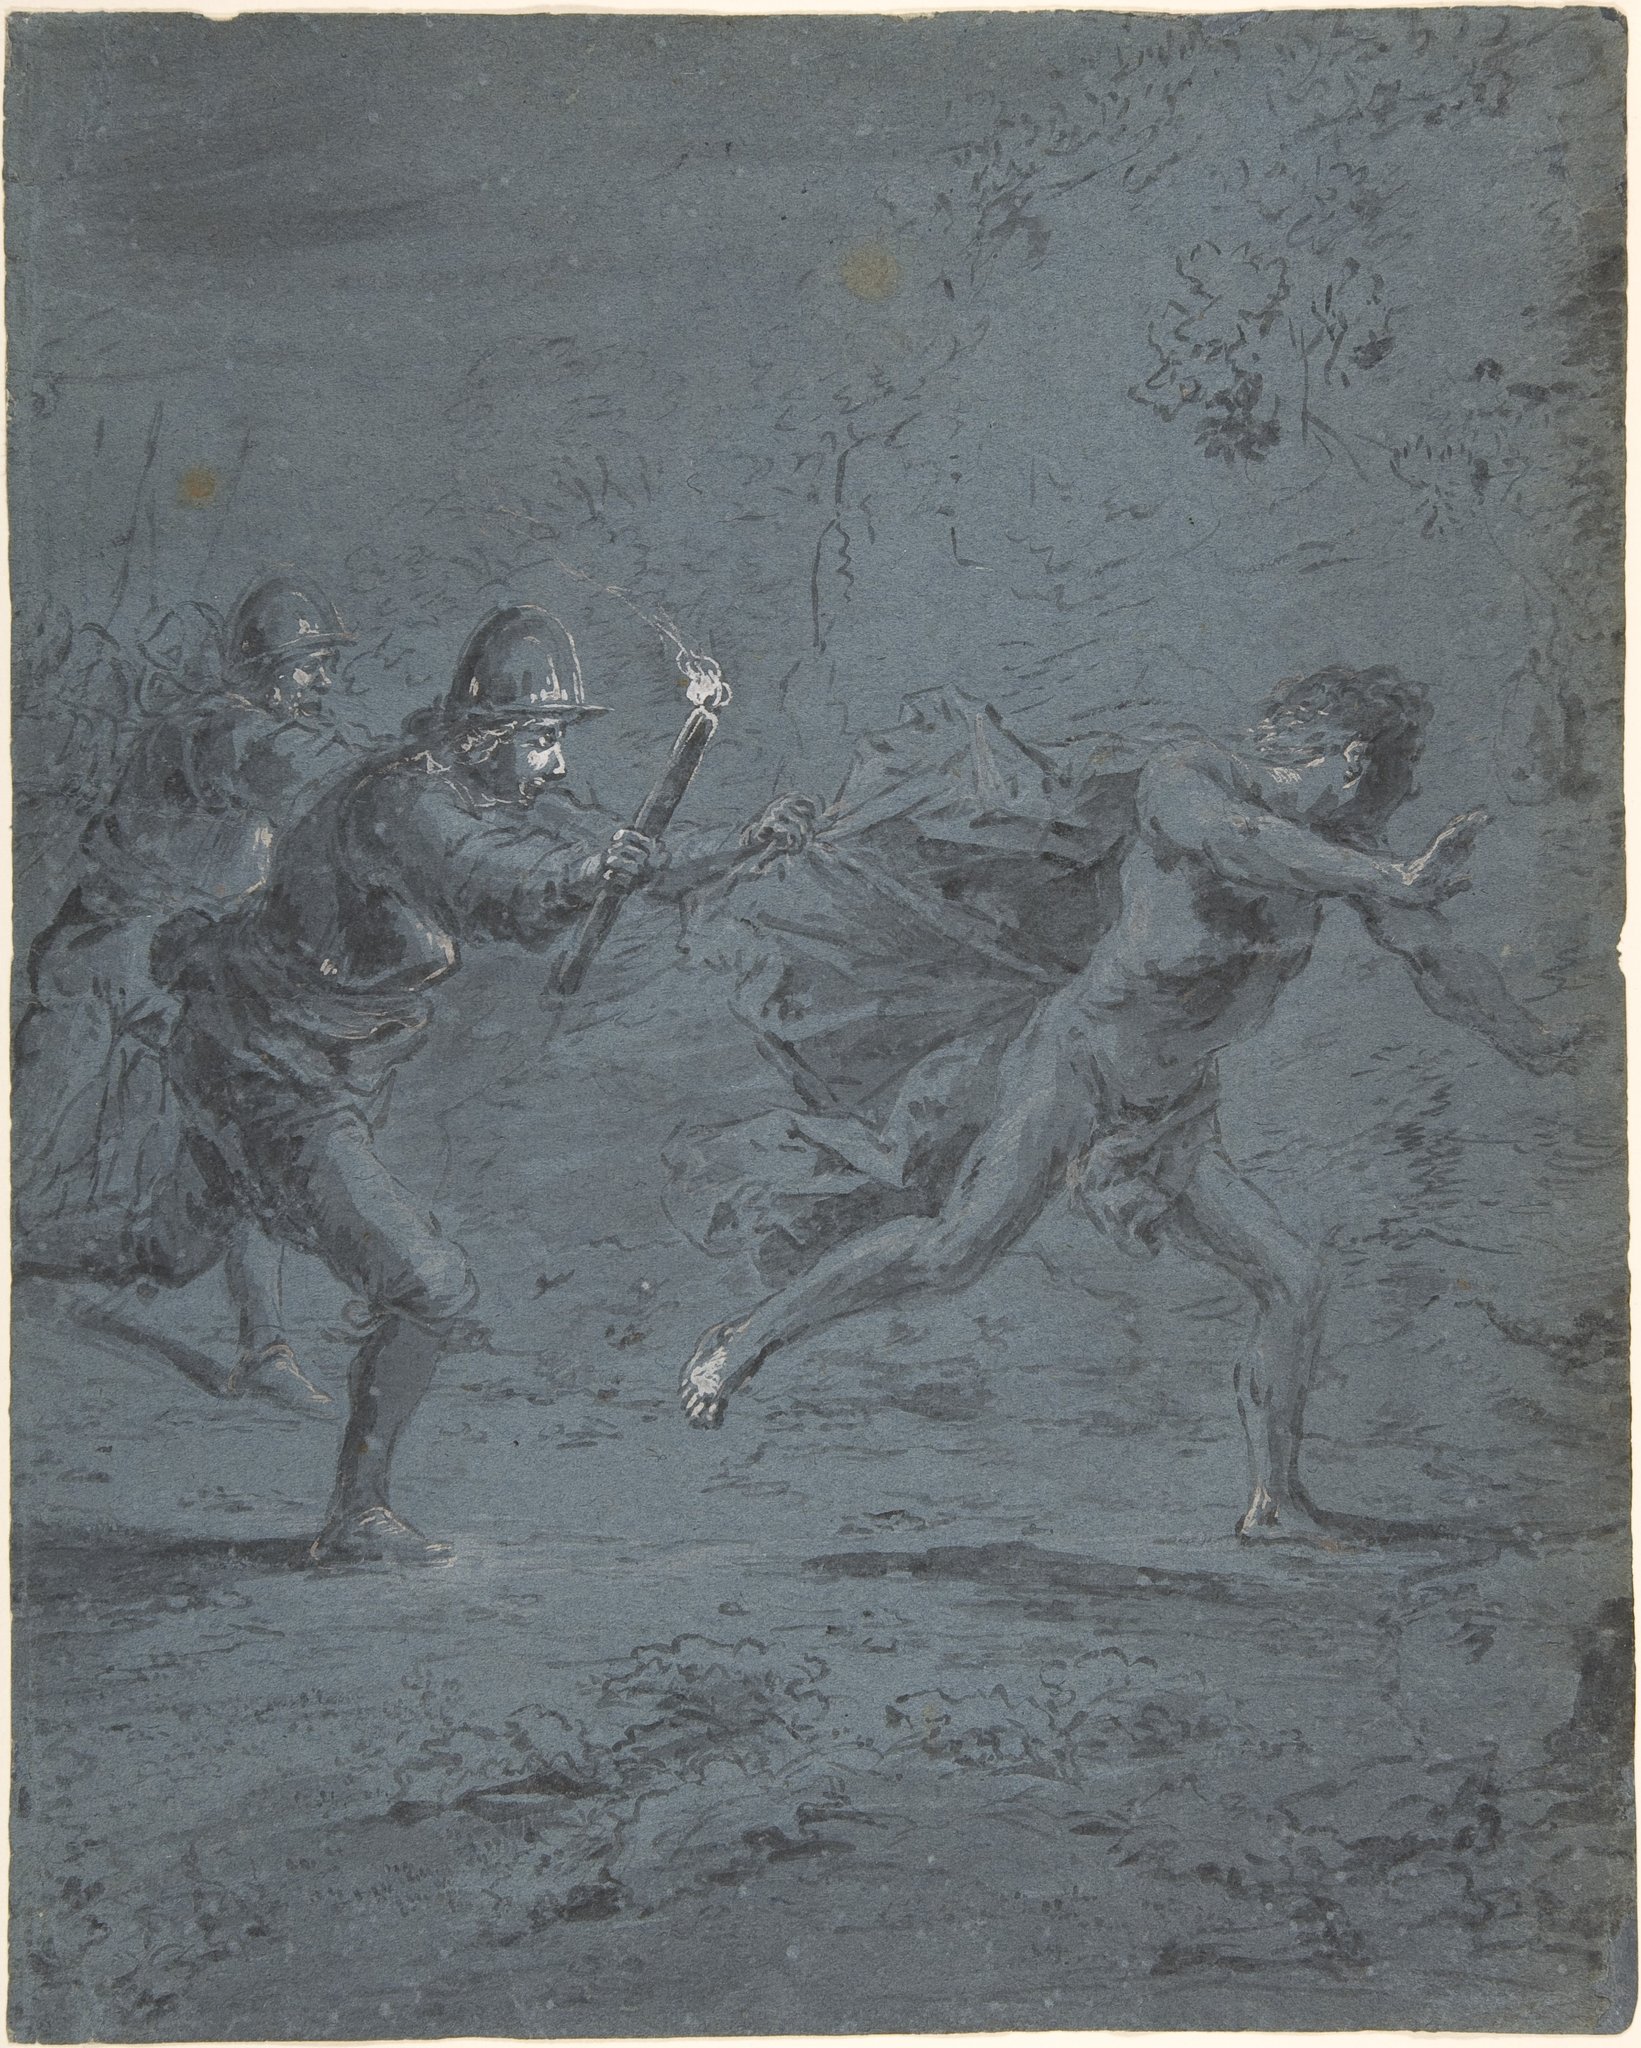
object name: drawing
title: Night scene with soldiers chasing a fugitive (Mark XIV, 5-52)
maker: leonaert bramer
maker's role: artist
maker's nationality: dutch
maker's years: 1596-1674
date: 1611-1674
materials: gouache, ink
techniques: brush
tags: soldiers,men,night